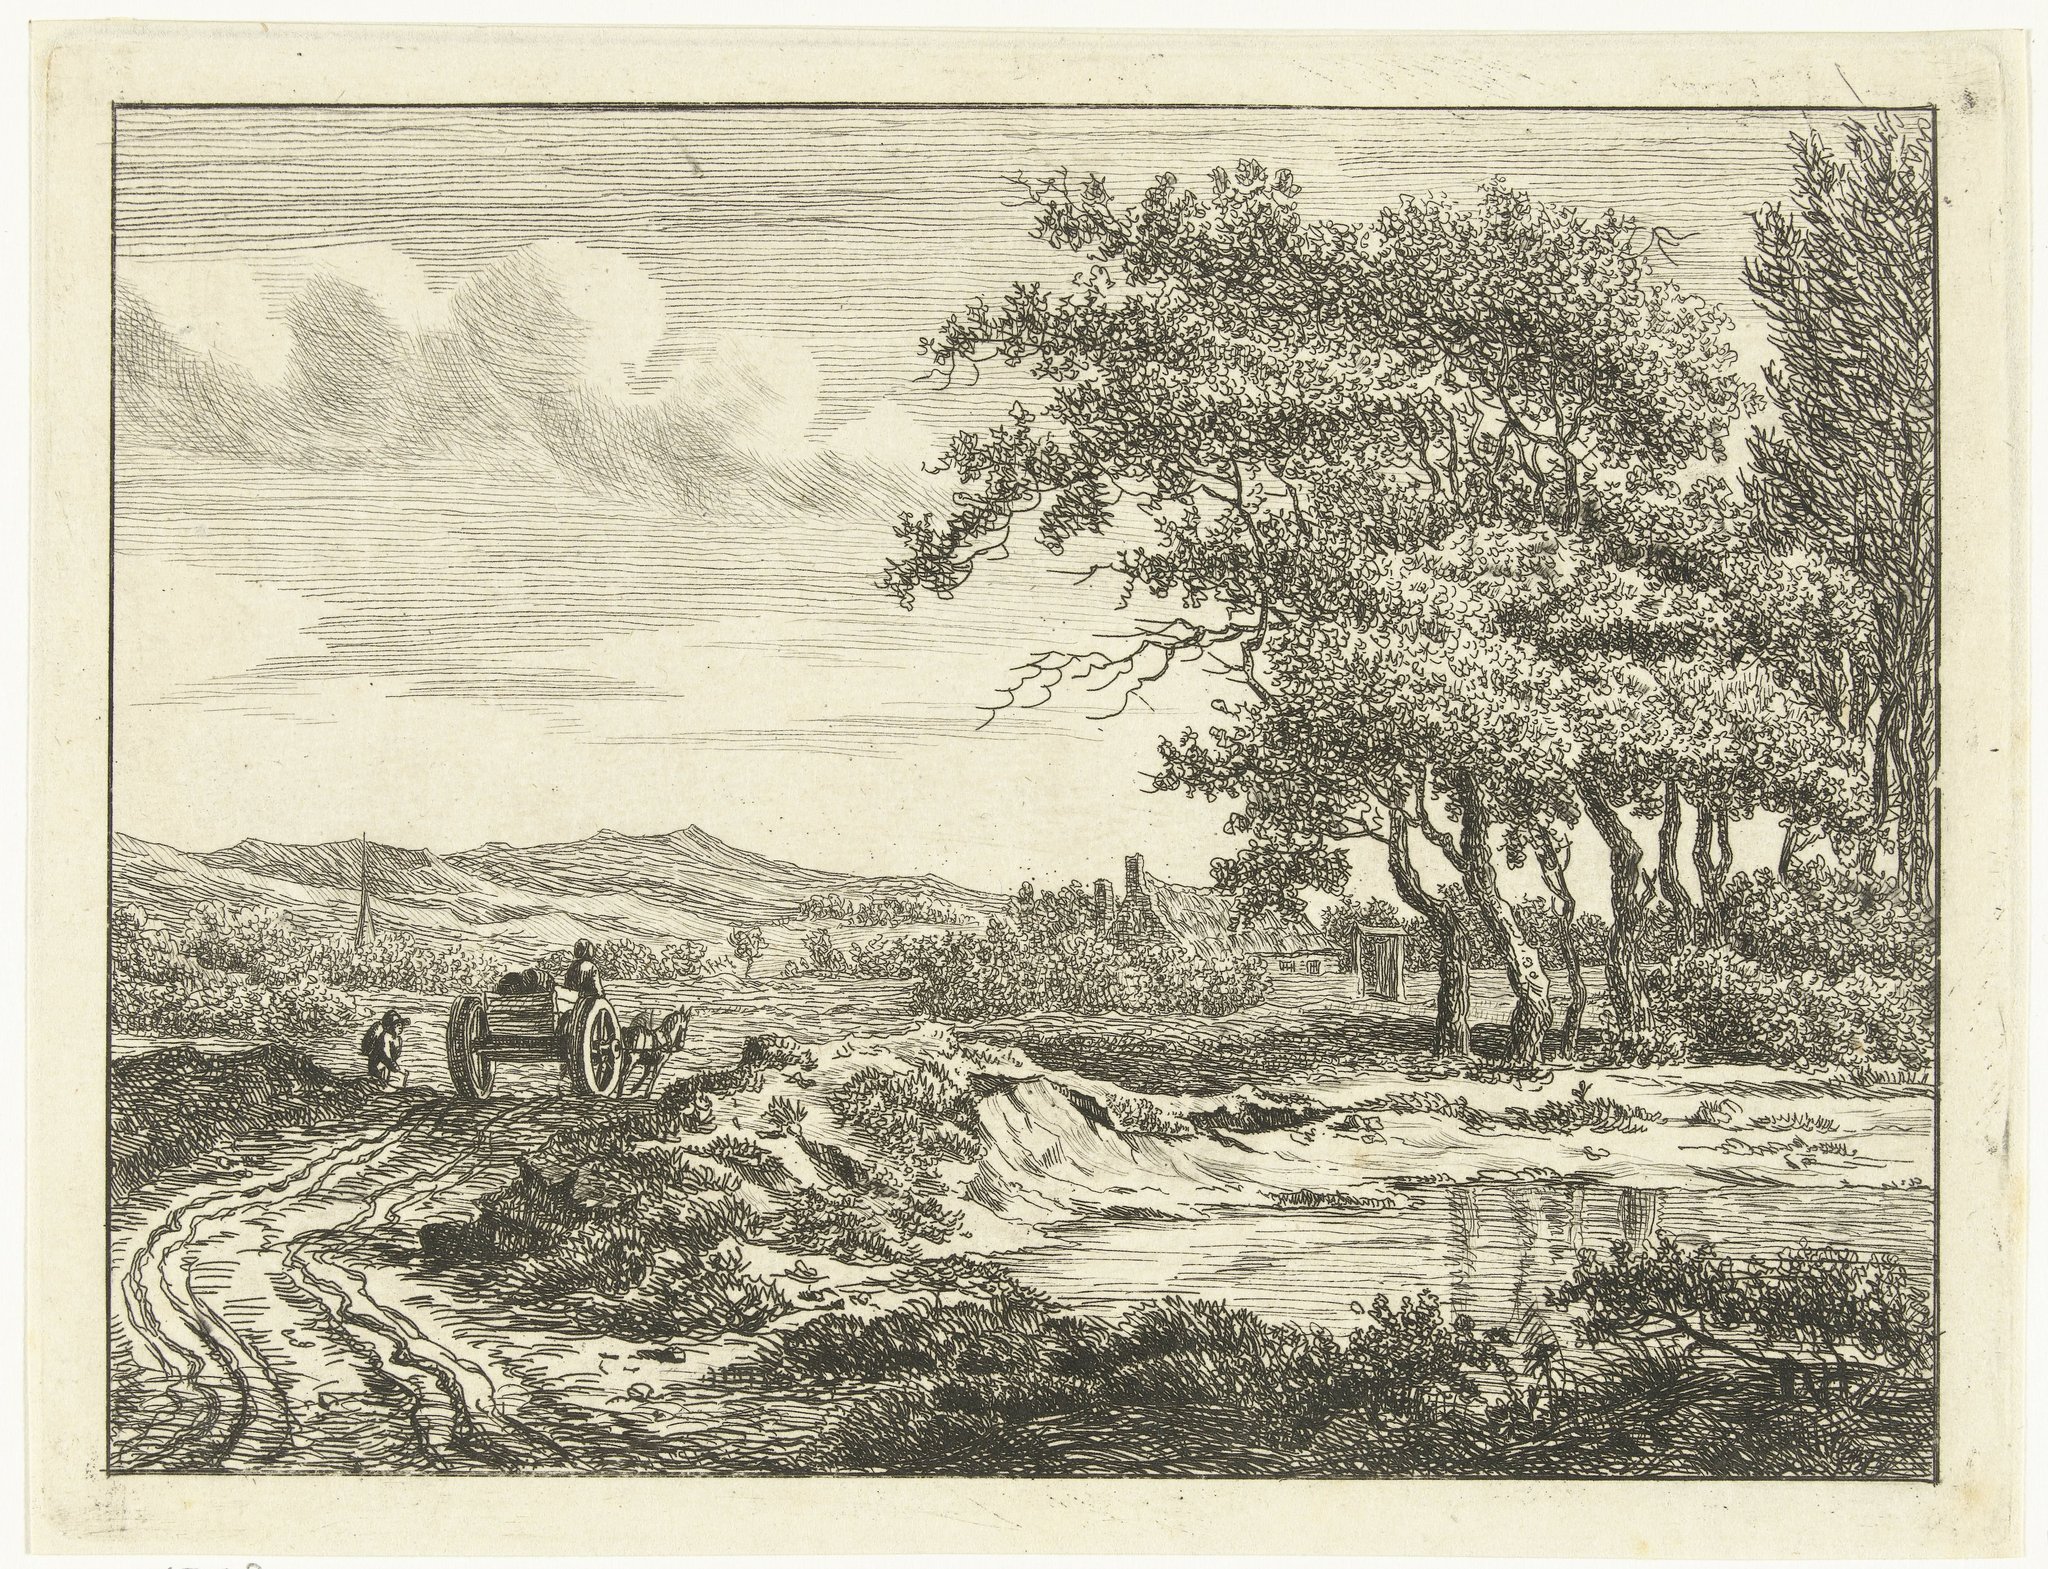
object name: print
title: Kar op een landweg bij de duinen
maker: anthonie van den bos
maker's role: draughtsman, print maker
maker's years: 1763-1838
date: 1778-1838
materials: paper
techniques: etching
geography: netherlands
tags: ruin of a dwelling, house, castle, etc.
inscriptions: collector's mark: Lugt 2228